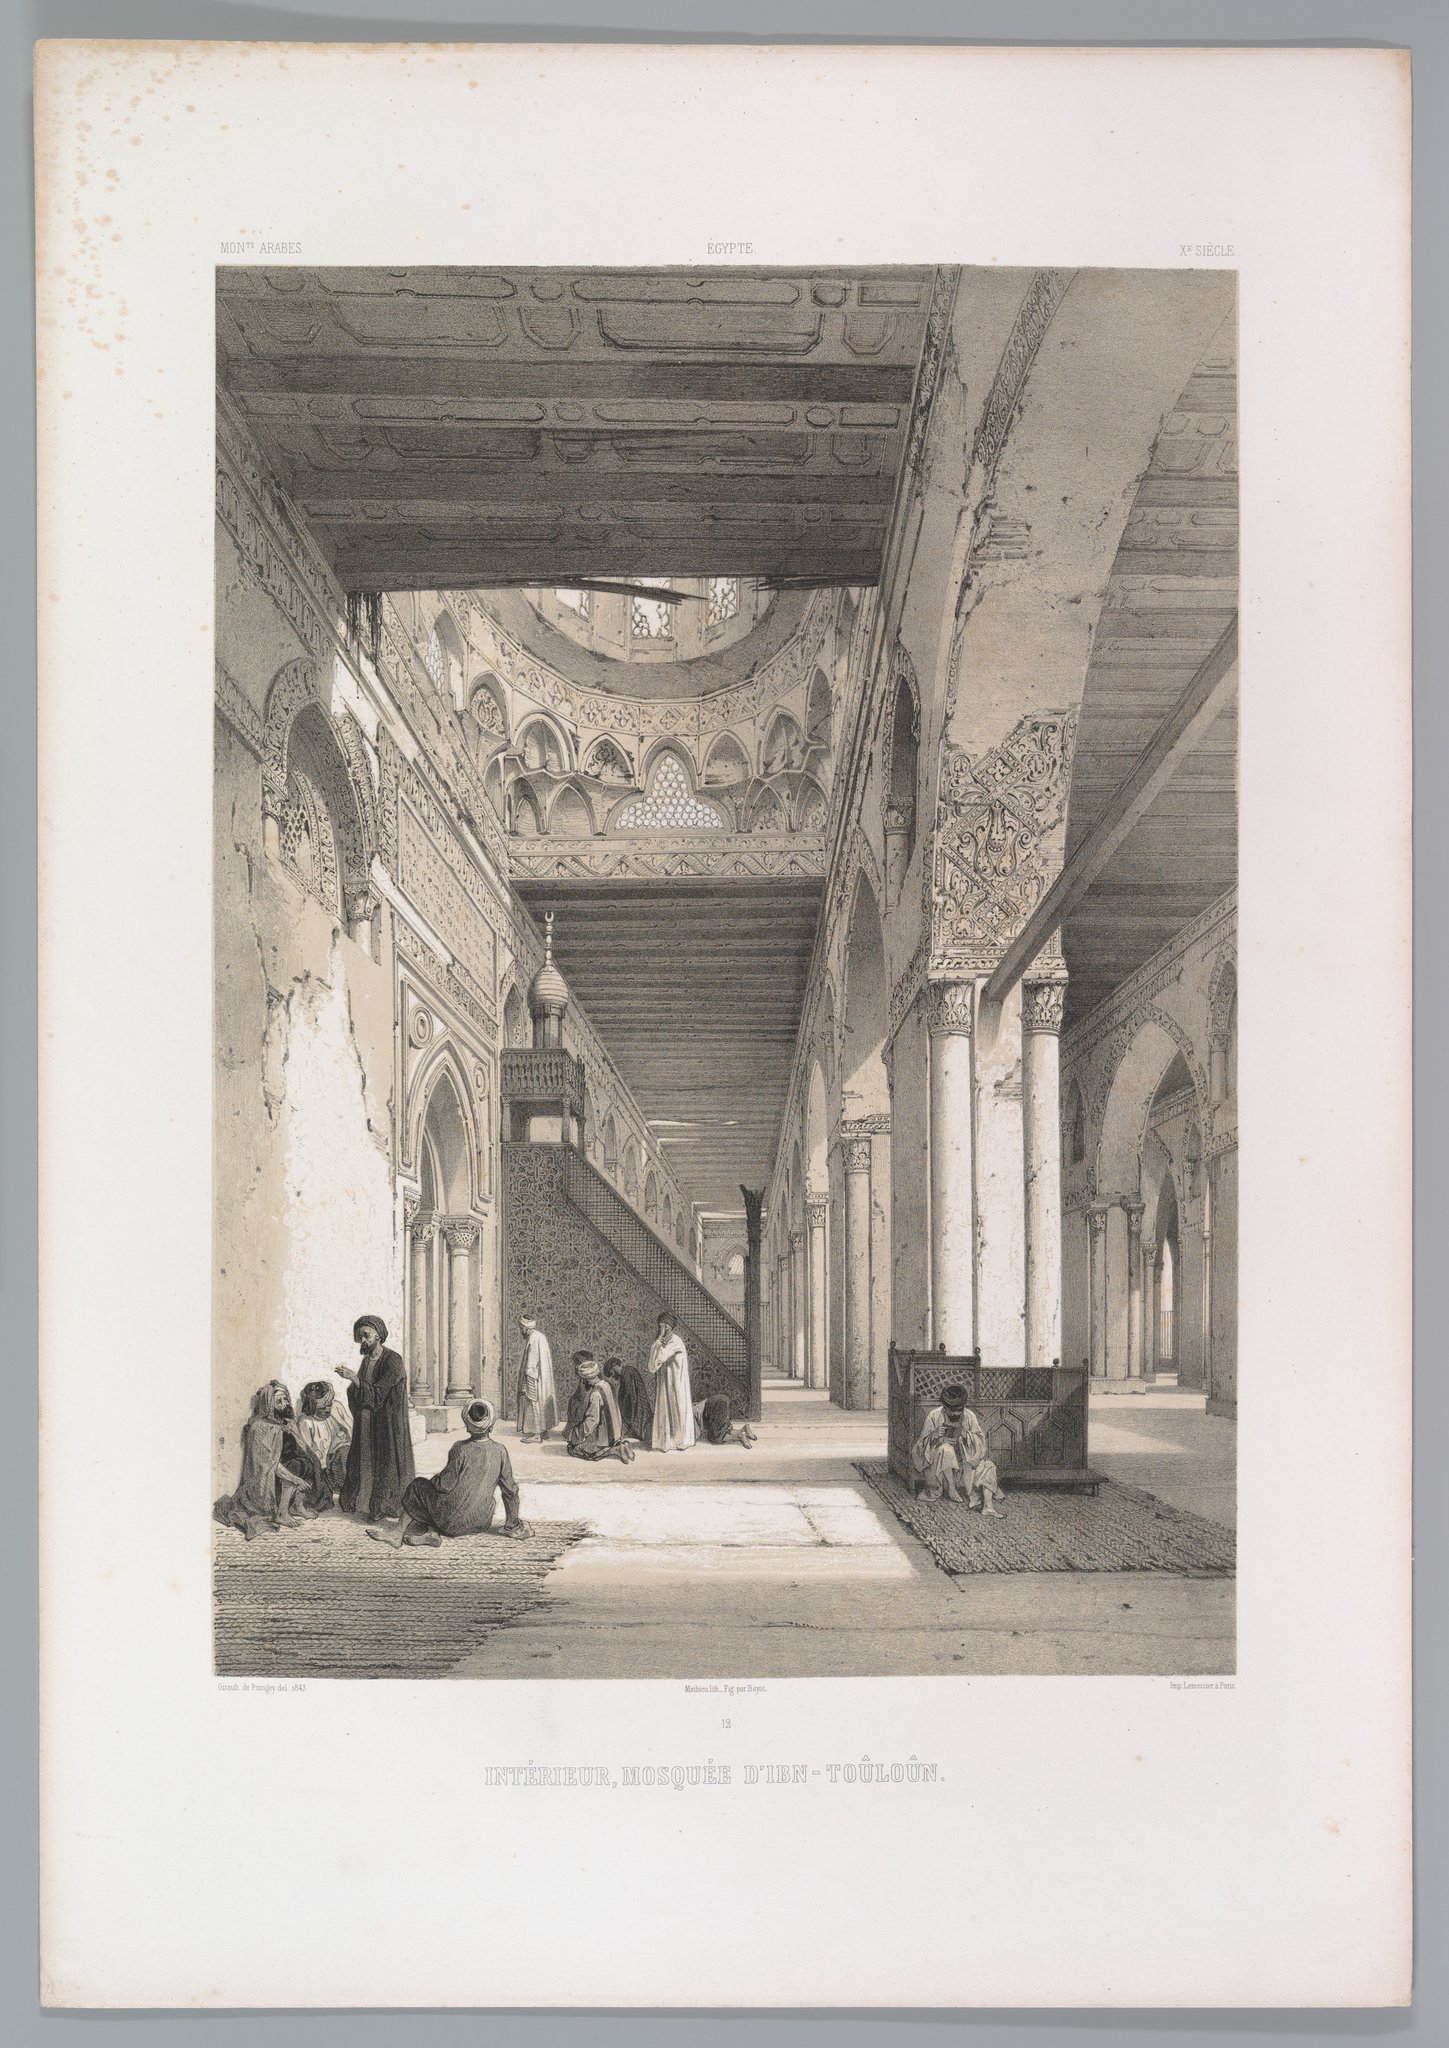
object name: lithograph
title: 12. Intérieur, Mosquée d’Ibn Toûloûn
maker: joseph-philibert girault de prangey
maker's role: artist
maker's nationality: french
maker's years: 1804-1892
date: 1843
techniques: lithograph